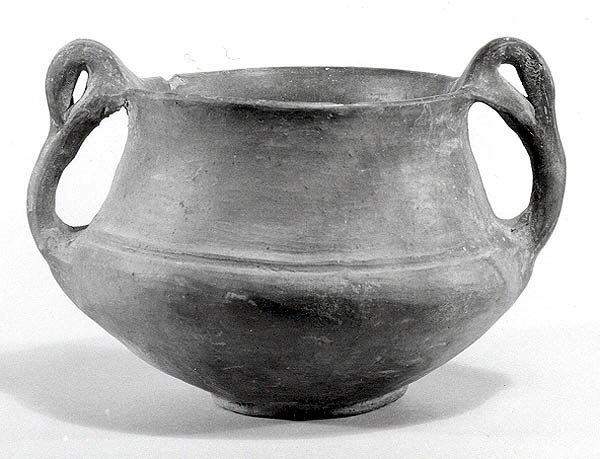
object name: bowl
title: Bowl with handles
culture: iranian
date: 900-801 BCE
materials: ceramic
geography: iran